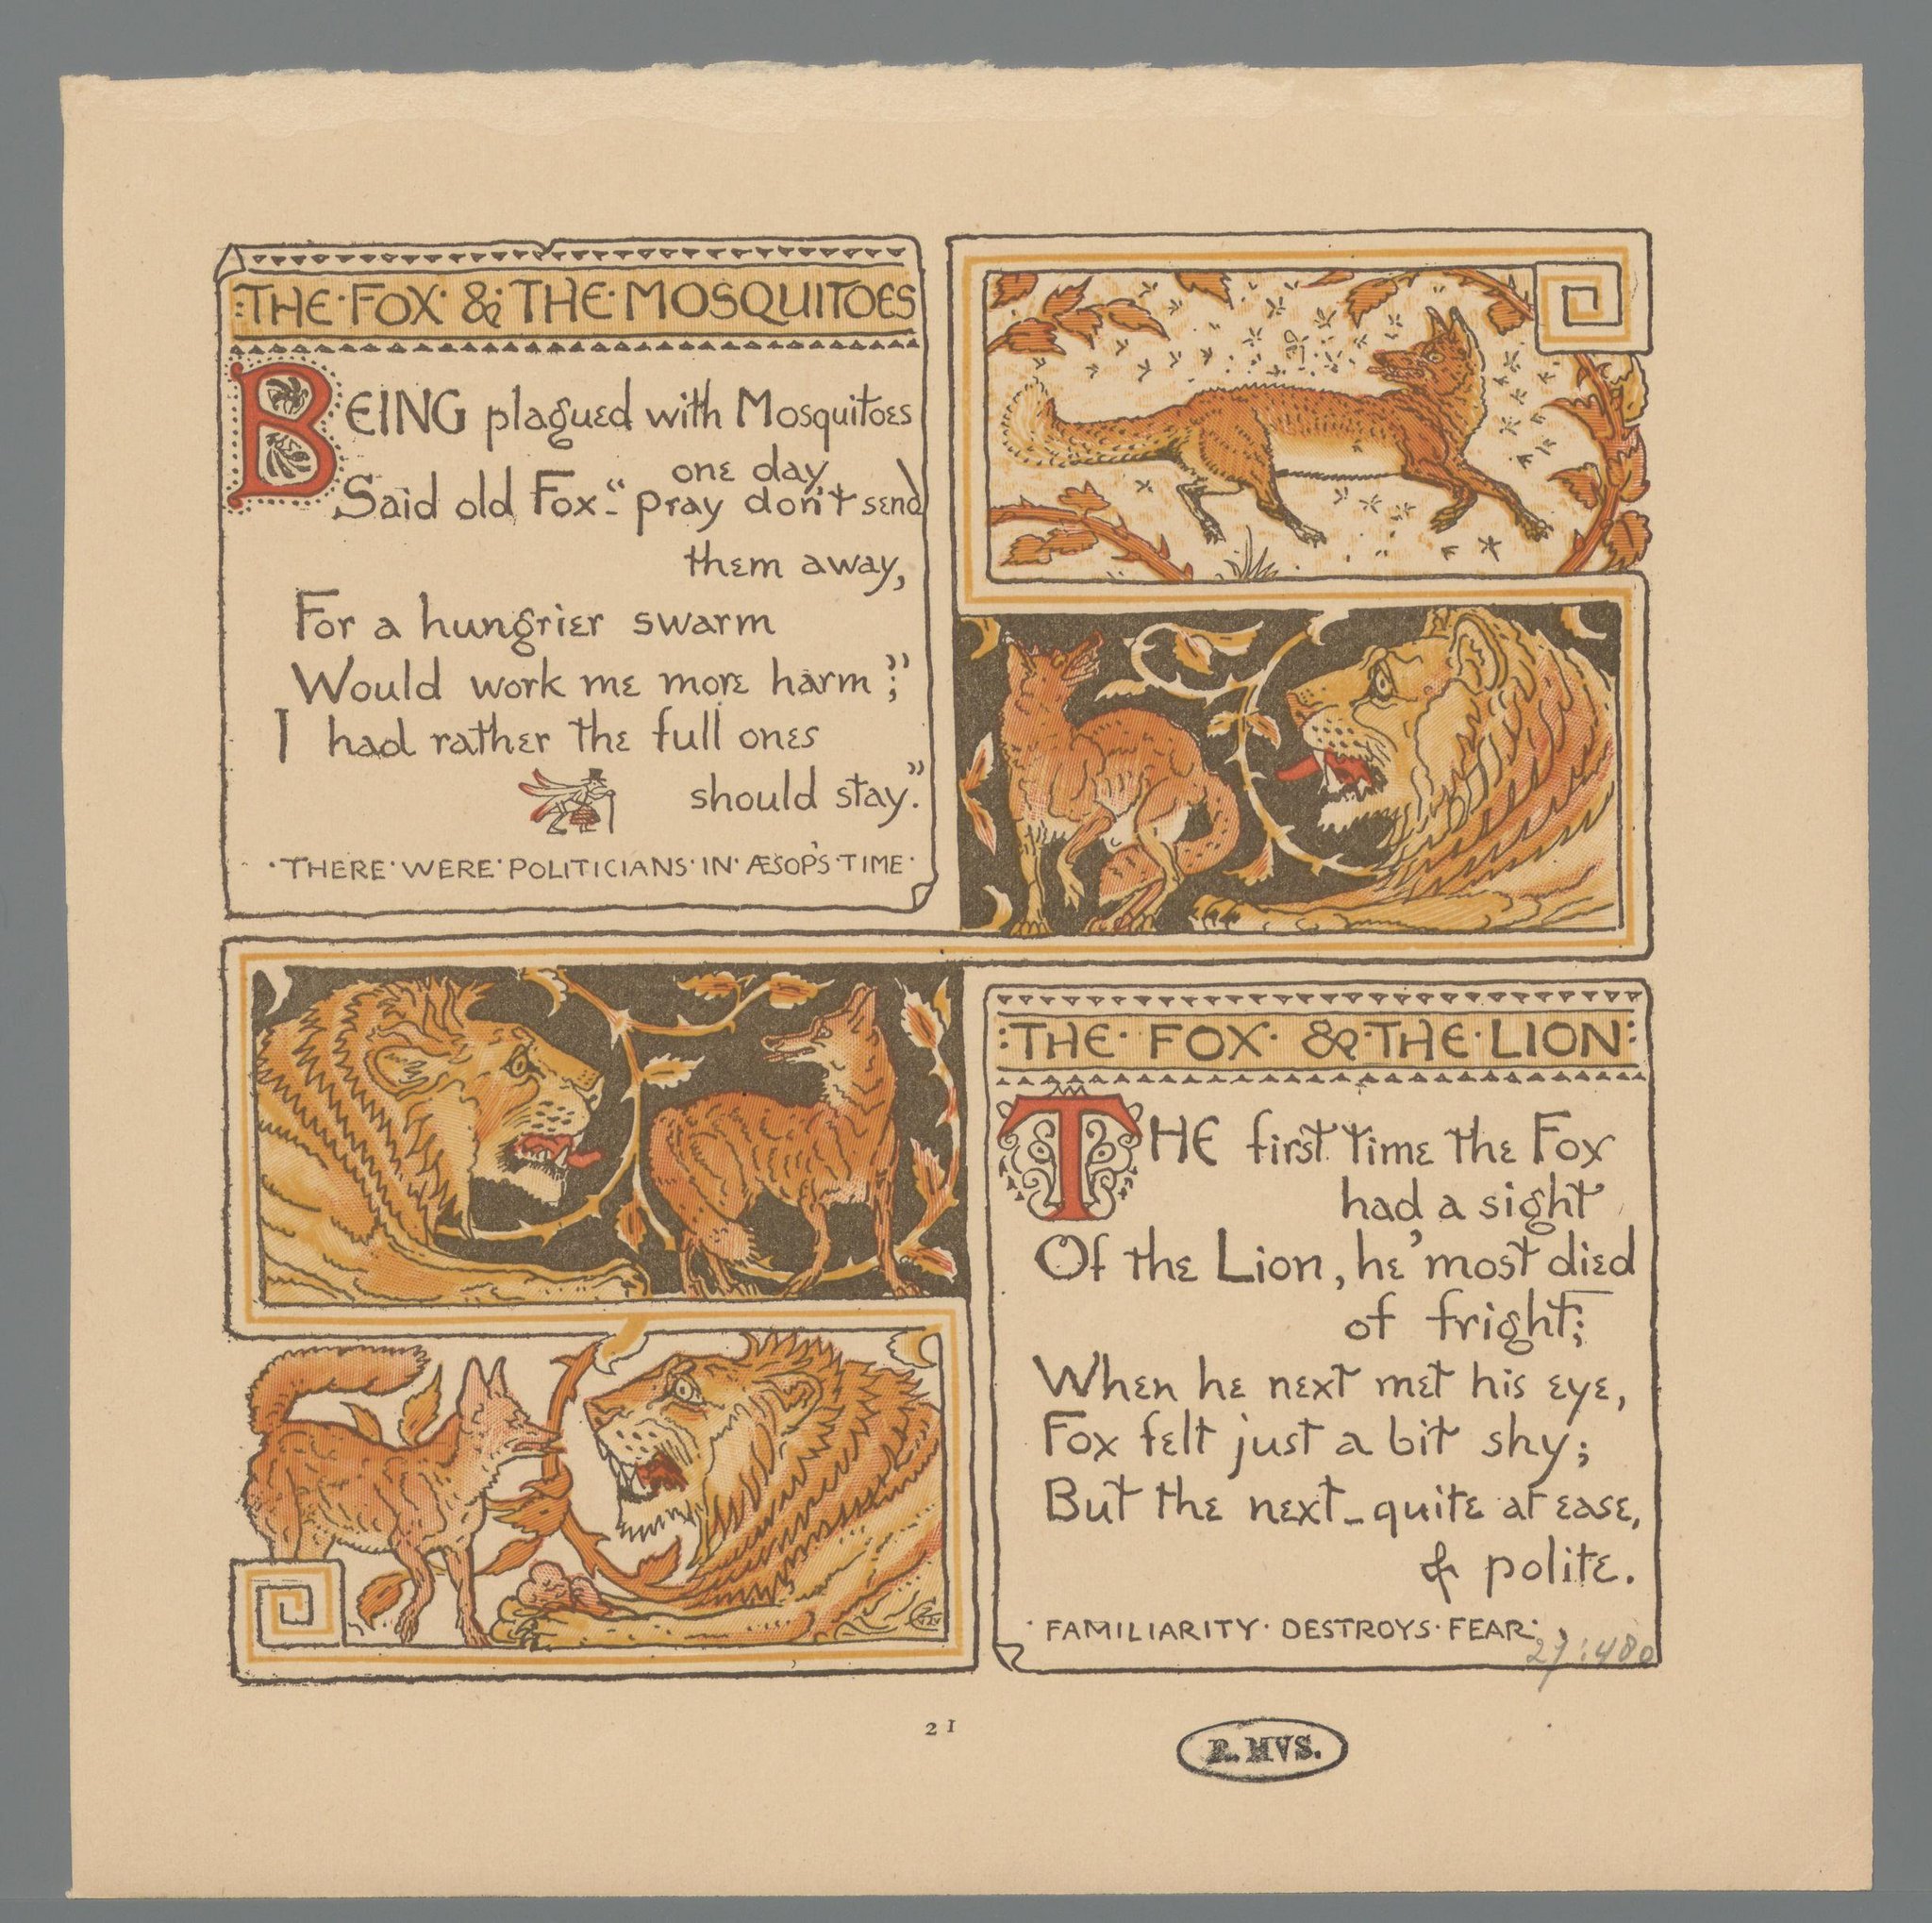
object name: print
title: Vos, leeuw en muggen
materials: paper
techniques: wood engraving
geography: london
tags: beasts of prey, predatory animals: lion, beasts of prey, predatory animals: fox, insects: mosquito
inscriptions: collector's mark: Lugt 2228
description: Prent uit: The baby's own Aesop being the fables condensed in rhyme. Londen: Routledge & Sons, 1887. Of een latere uitgave.